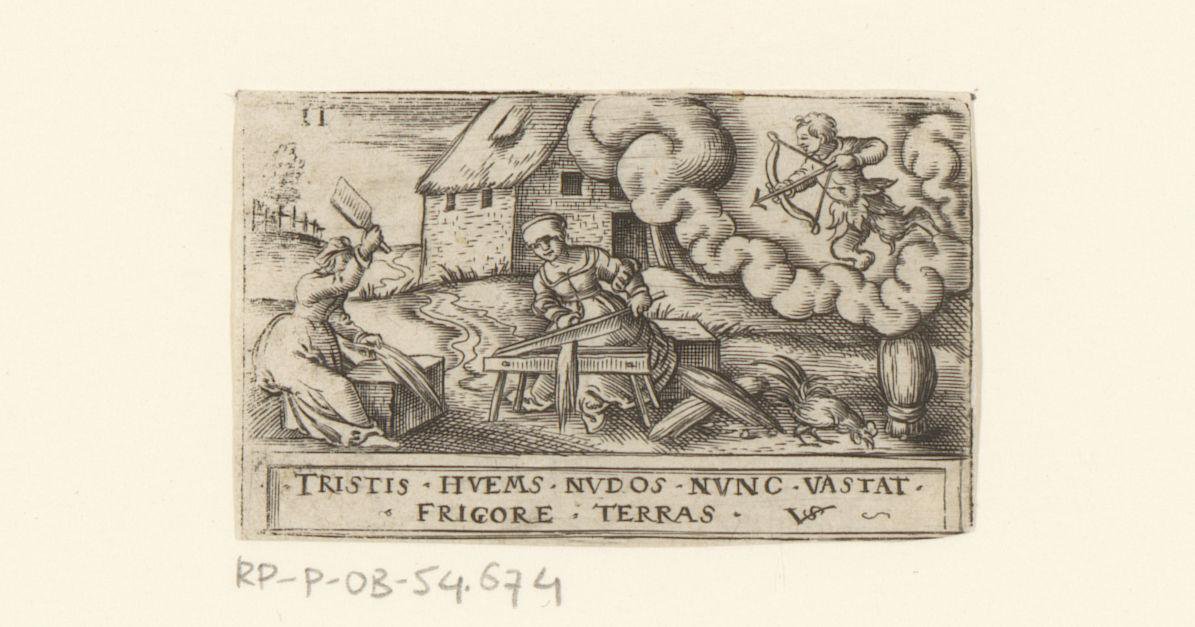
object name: print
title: November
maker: virgilius solis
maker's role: draughtsman, print maker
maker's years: 1514-1562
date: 1524-1562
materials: paper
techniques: engraving, etching, intaglio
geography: nuremberg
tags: november and its 'labours', sagittarius (zodiacal sign of november)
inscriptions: collector's mark: Lugt 2228, number: ‘57’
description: Maakt deel uit van een serie van twaalf prenten met verbeeldingen van de twaalf maanden. In de collectie Rijksmuseum bevinden zich negen van de twaalf originele prenten en de overige drie in kopie.